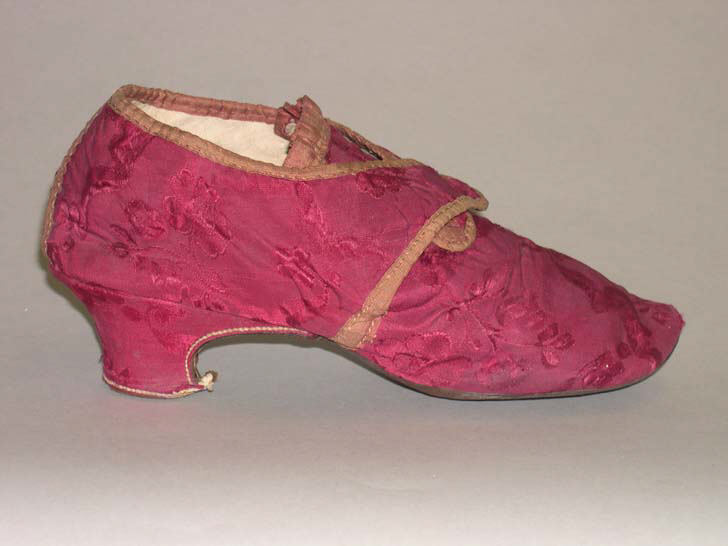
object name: shoe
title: Shoes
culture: italian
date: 1770-1789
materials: leather, silk